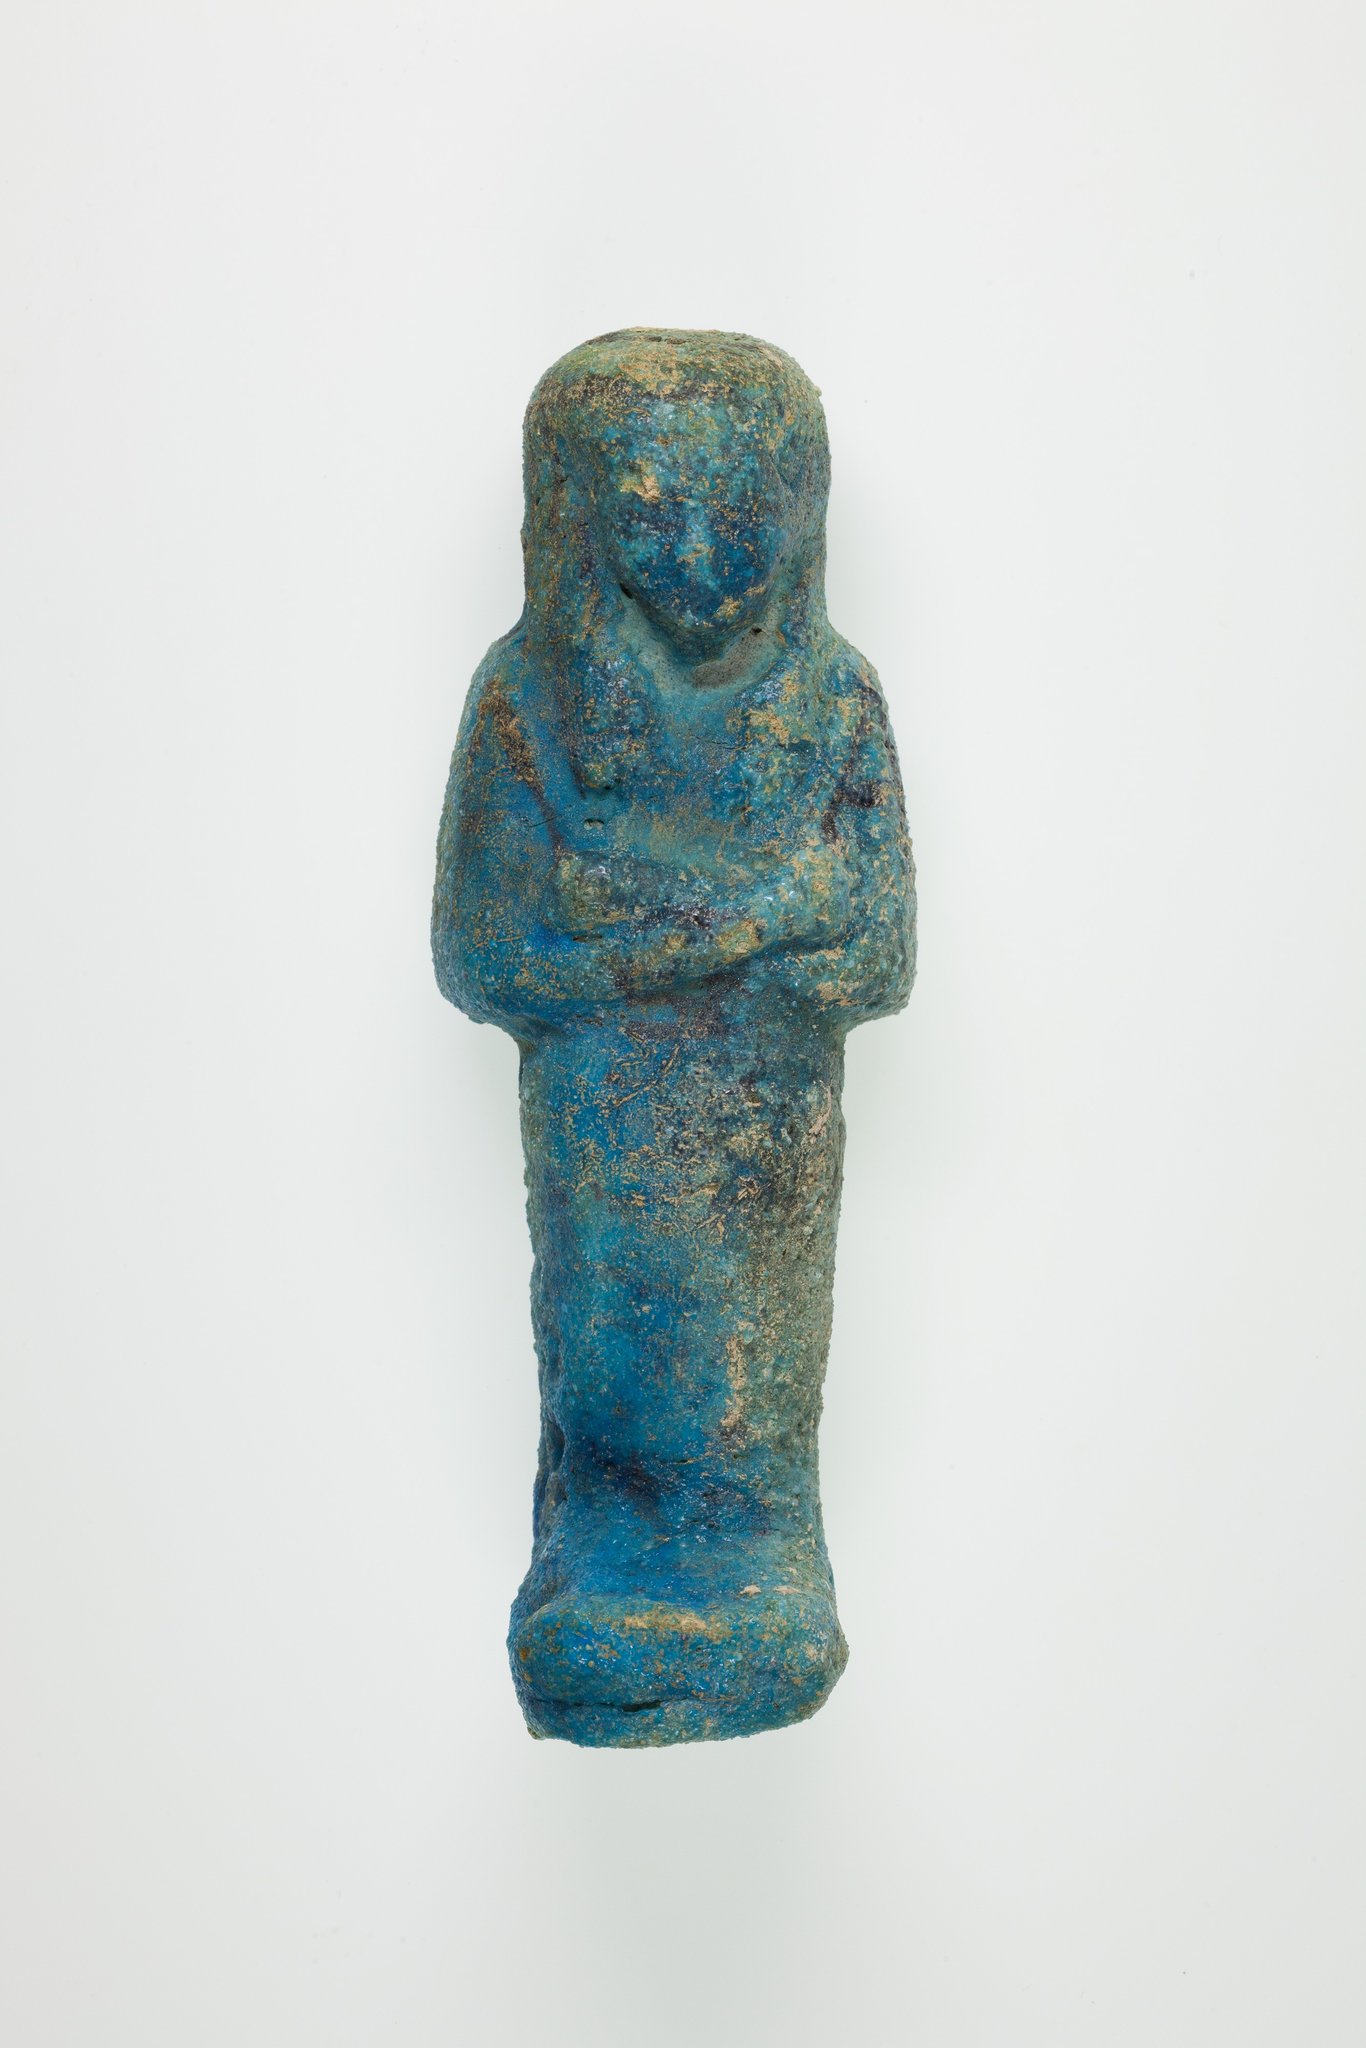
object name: shabti, henettawy c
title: Worker Shabti of Henettawy (C), Daughter of Isetemkheb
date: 990-970 BCE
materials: faience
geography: egypt